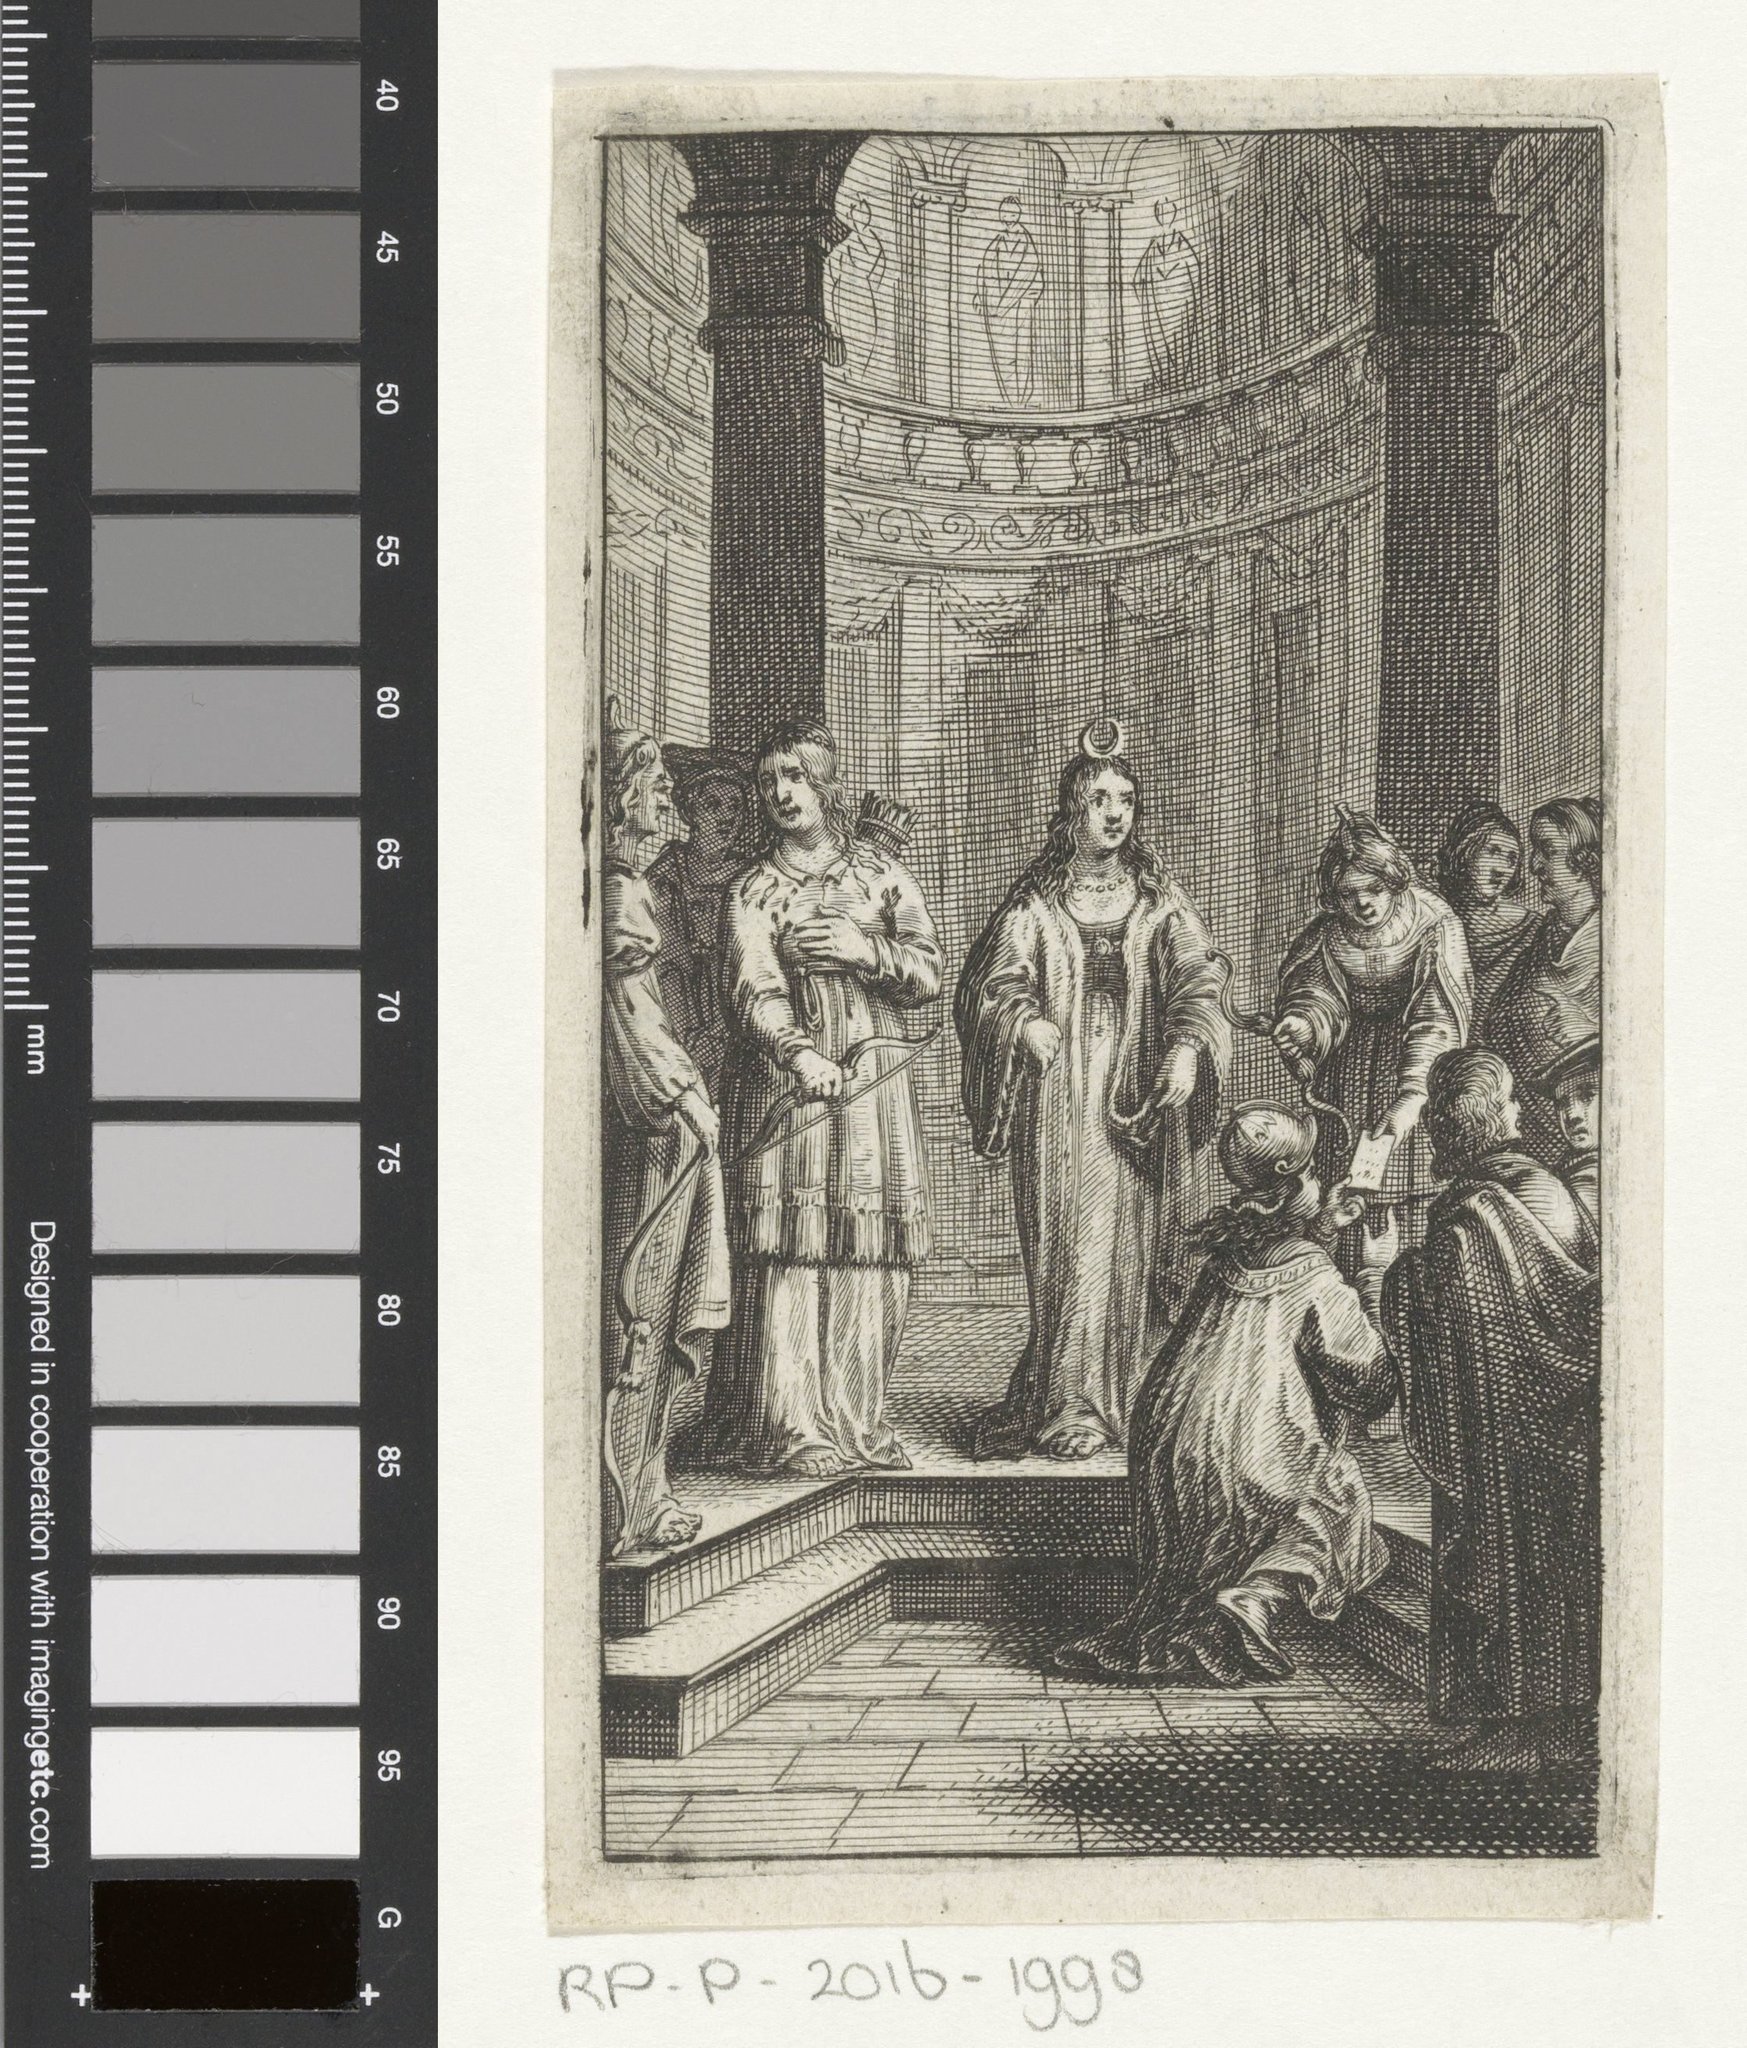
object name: print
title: Geknielde figuur geeft brief aan vrouwelijke jager in aanwezigheid van Diana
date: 1644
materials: paper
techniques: etching, letterpress printing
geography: amsterdam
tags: (story of) diana (artemis), letter, envelope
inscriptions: collector's mark: Lugt 2228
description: Prent uit: Urfé, Honoré d'. D'Astrea. Amsterdam: Lootsman, Theunis Jacobsz, 1644. Prent afkomstig uit een plakalbum met titelprenten, ornamenten etc. op blauw papier in 1983 uit elkaar gehaald.